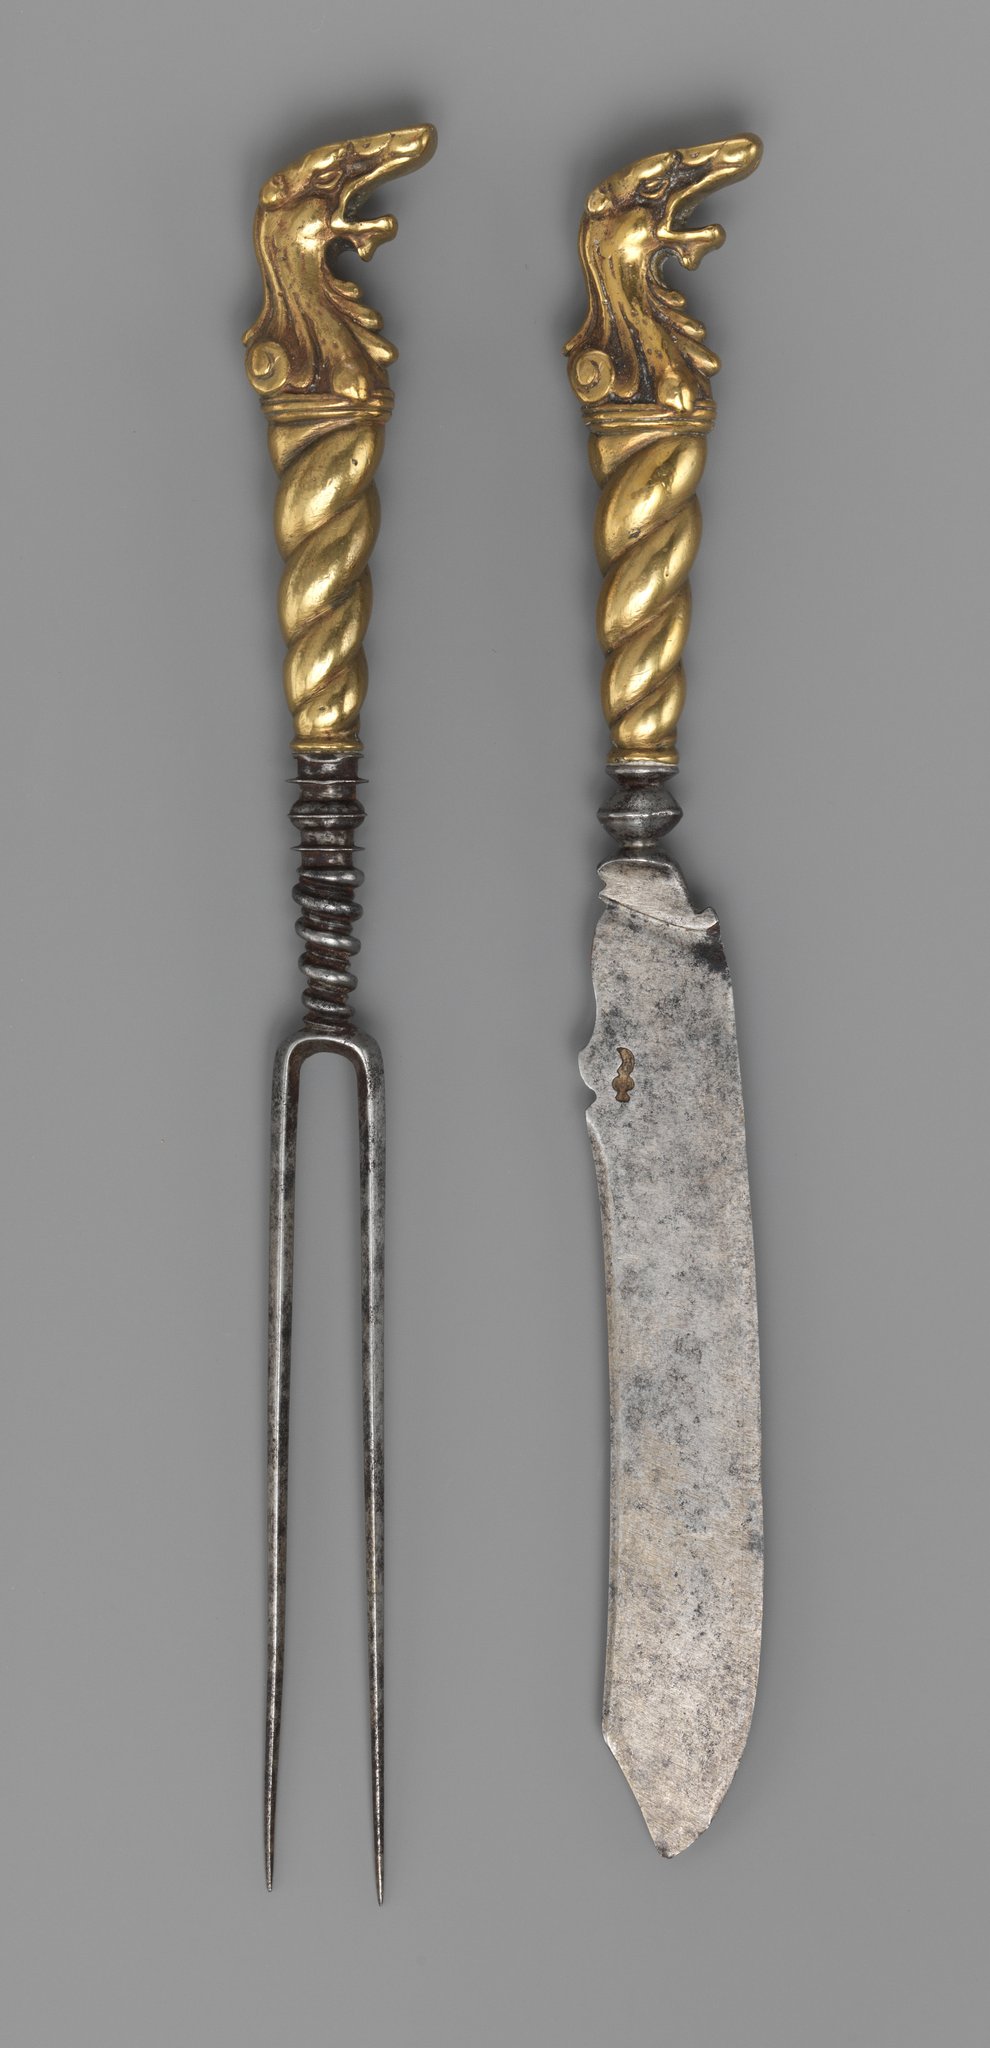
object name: table knife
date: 1601-1700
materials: brass, steel